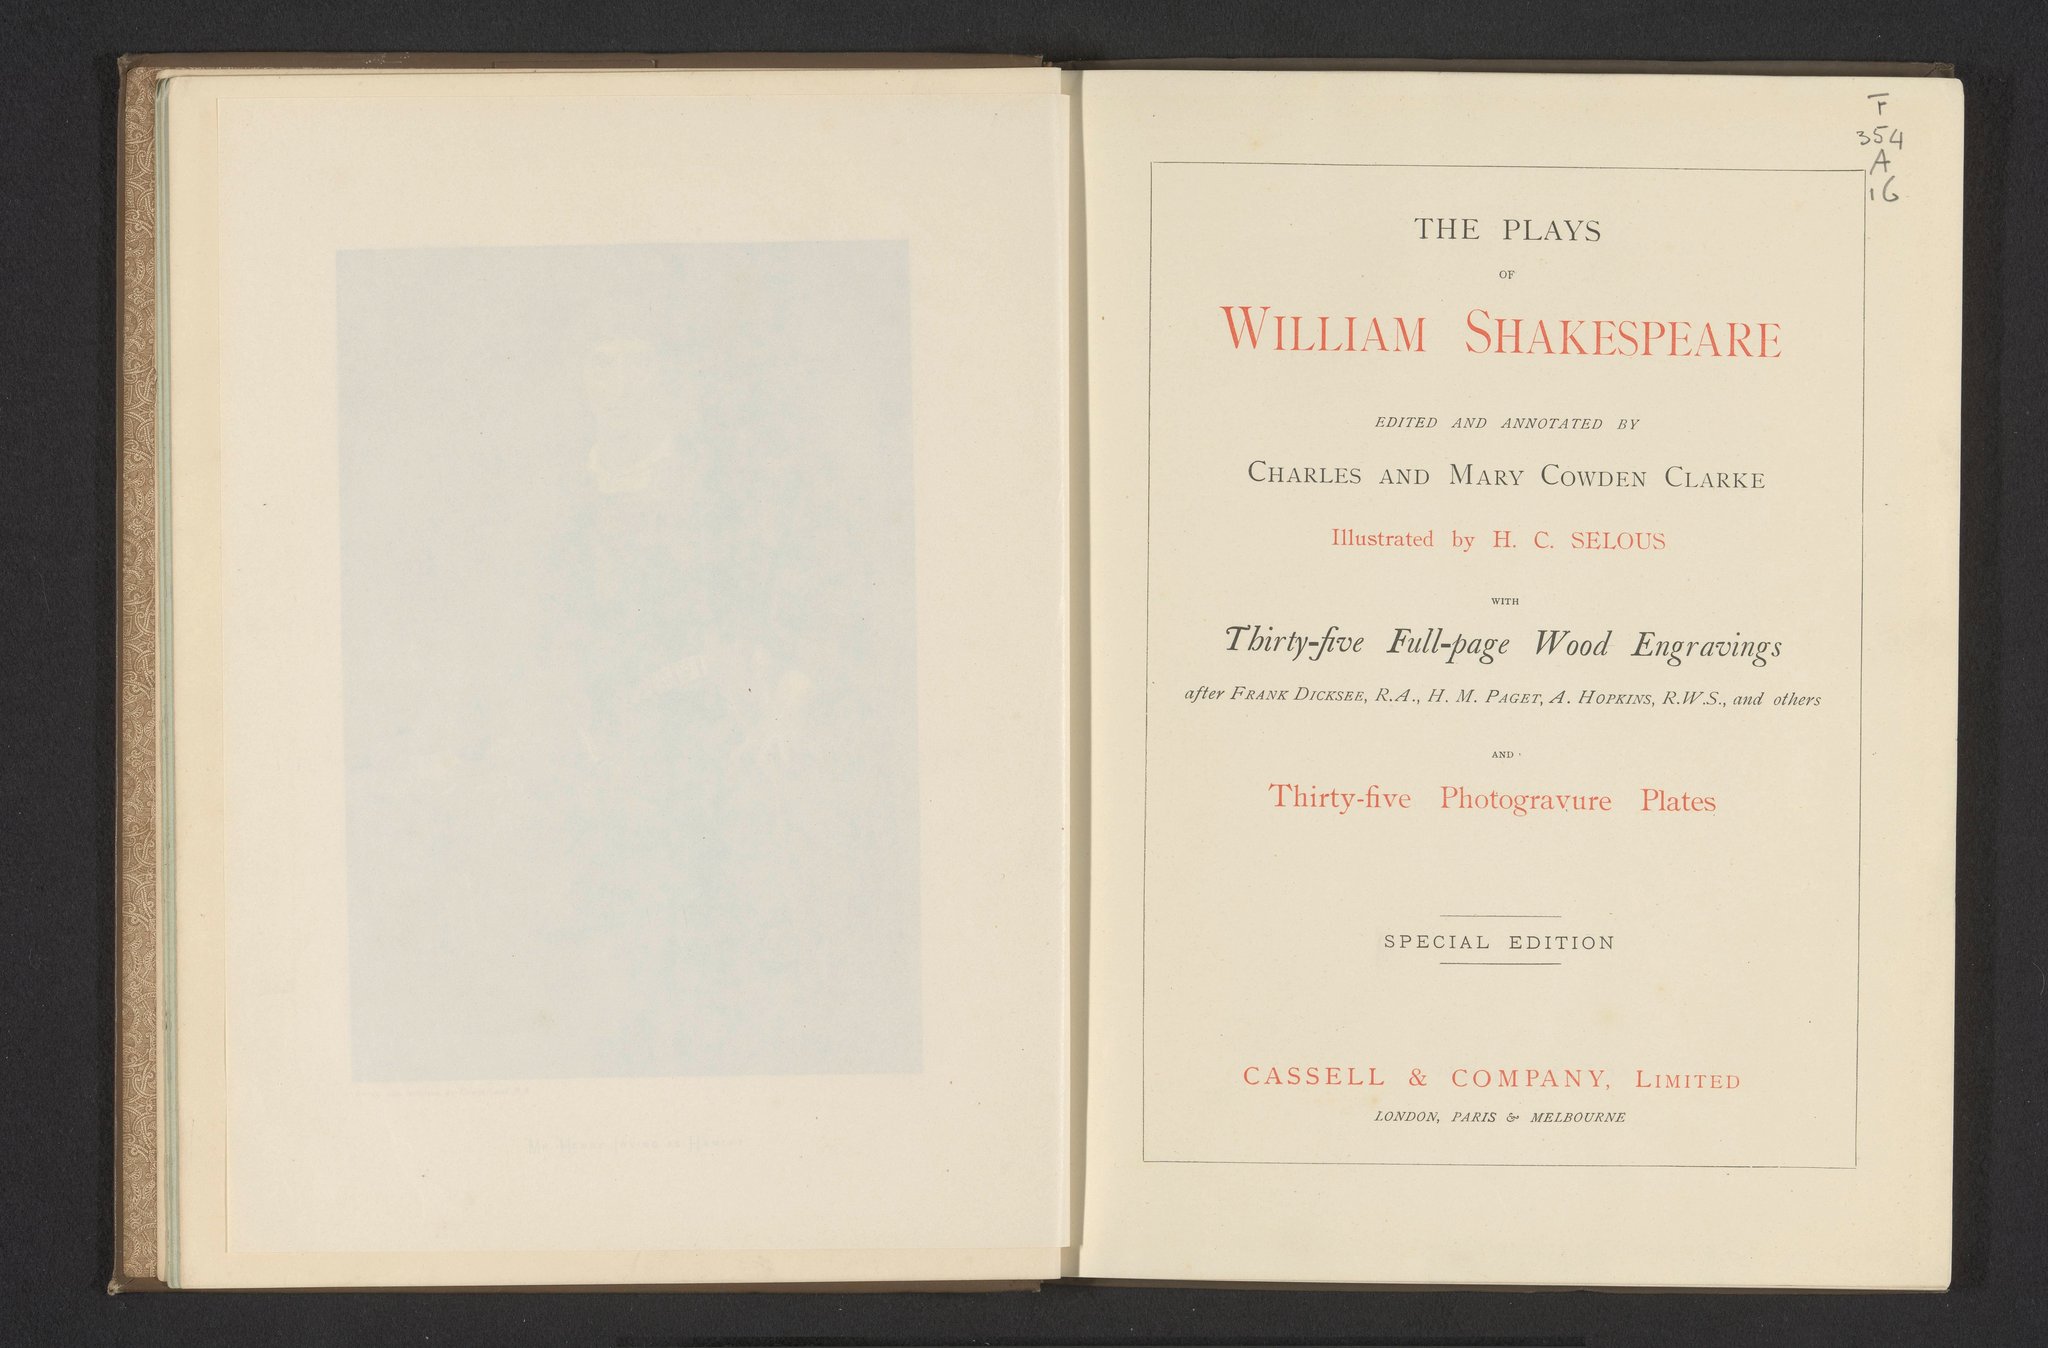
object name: book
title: The plays of William Shakespeare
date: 1893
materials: cardboard, linen, paper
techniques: engraving, photoaquatint, printing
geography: london